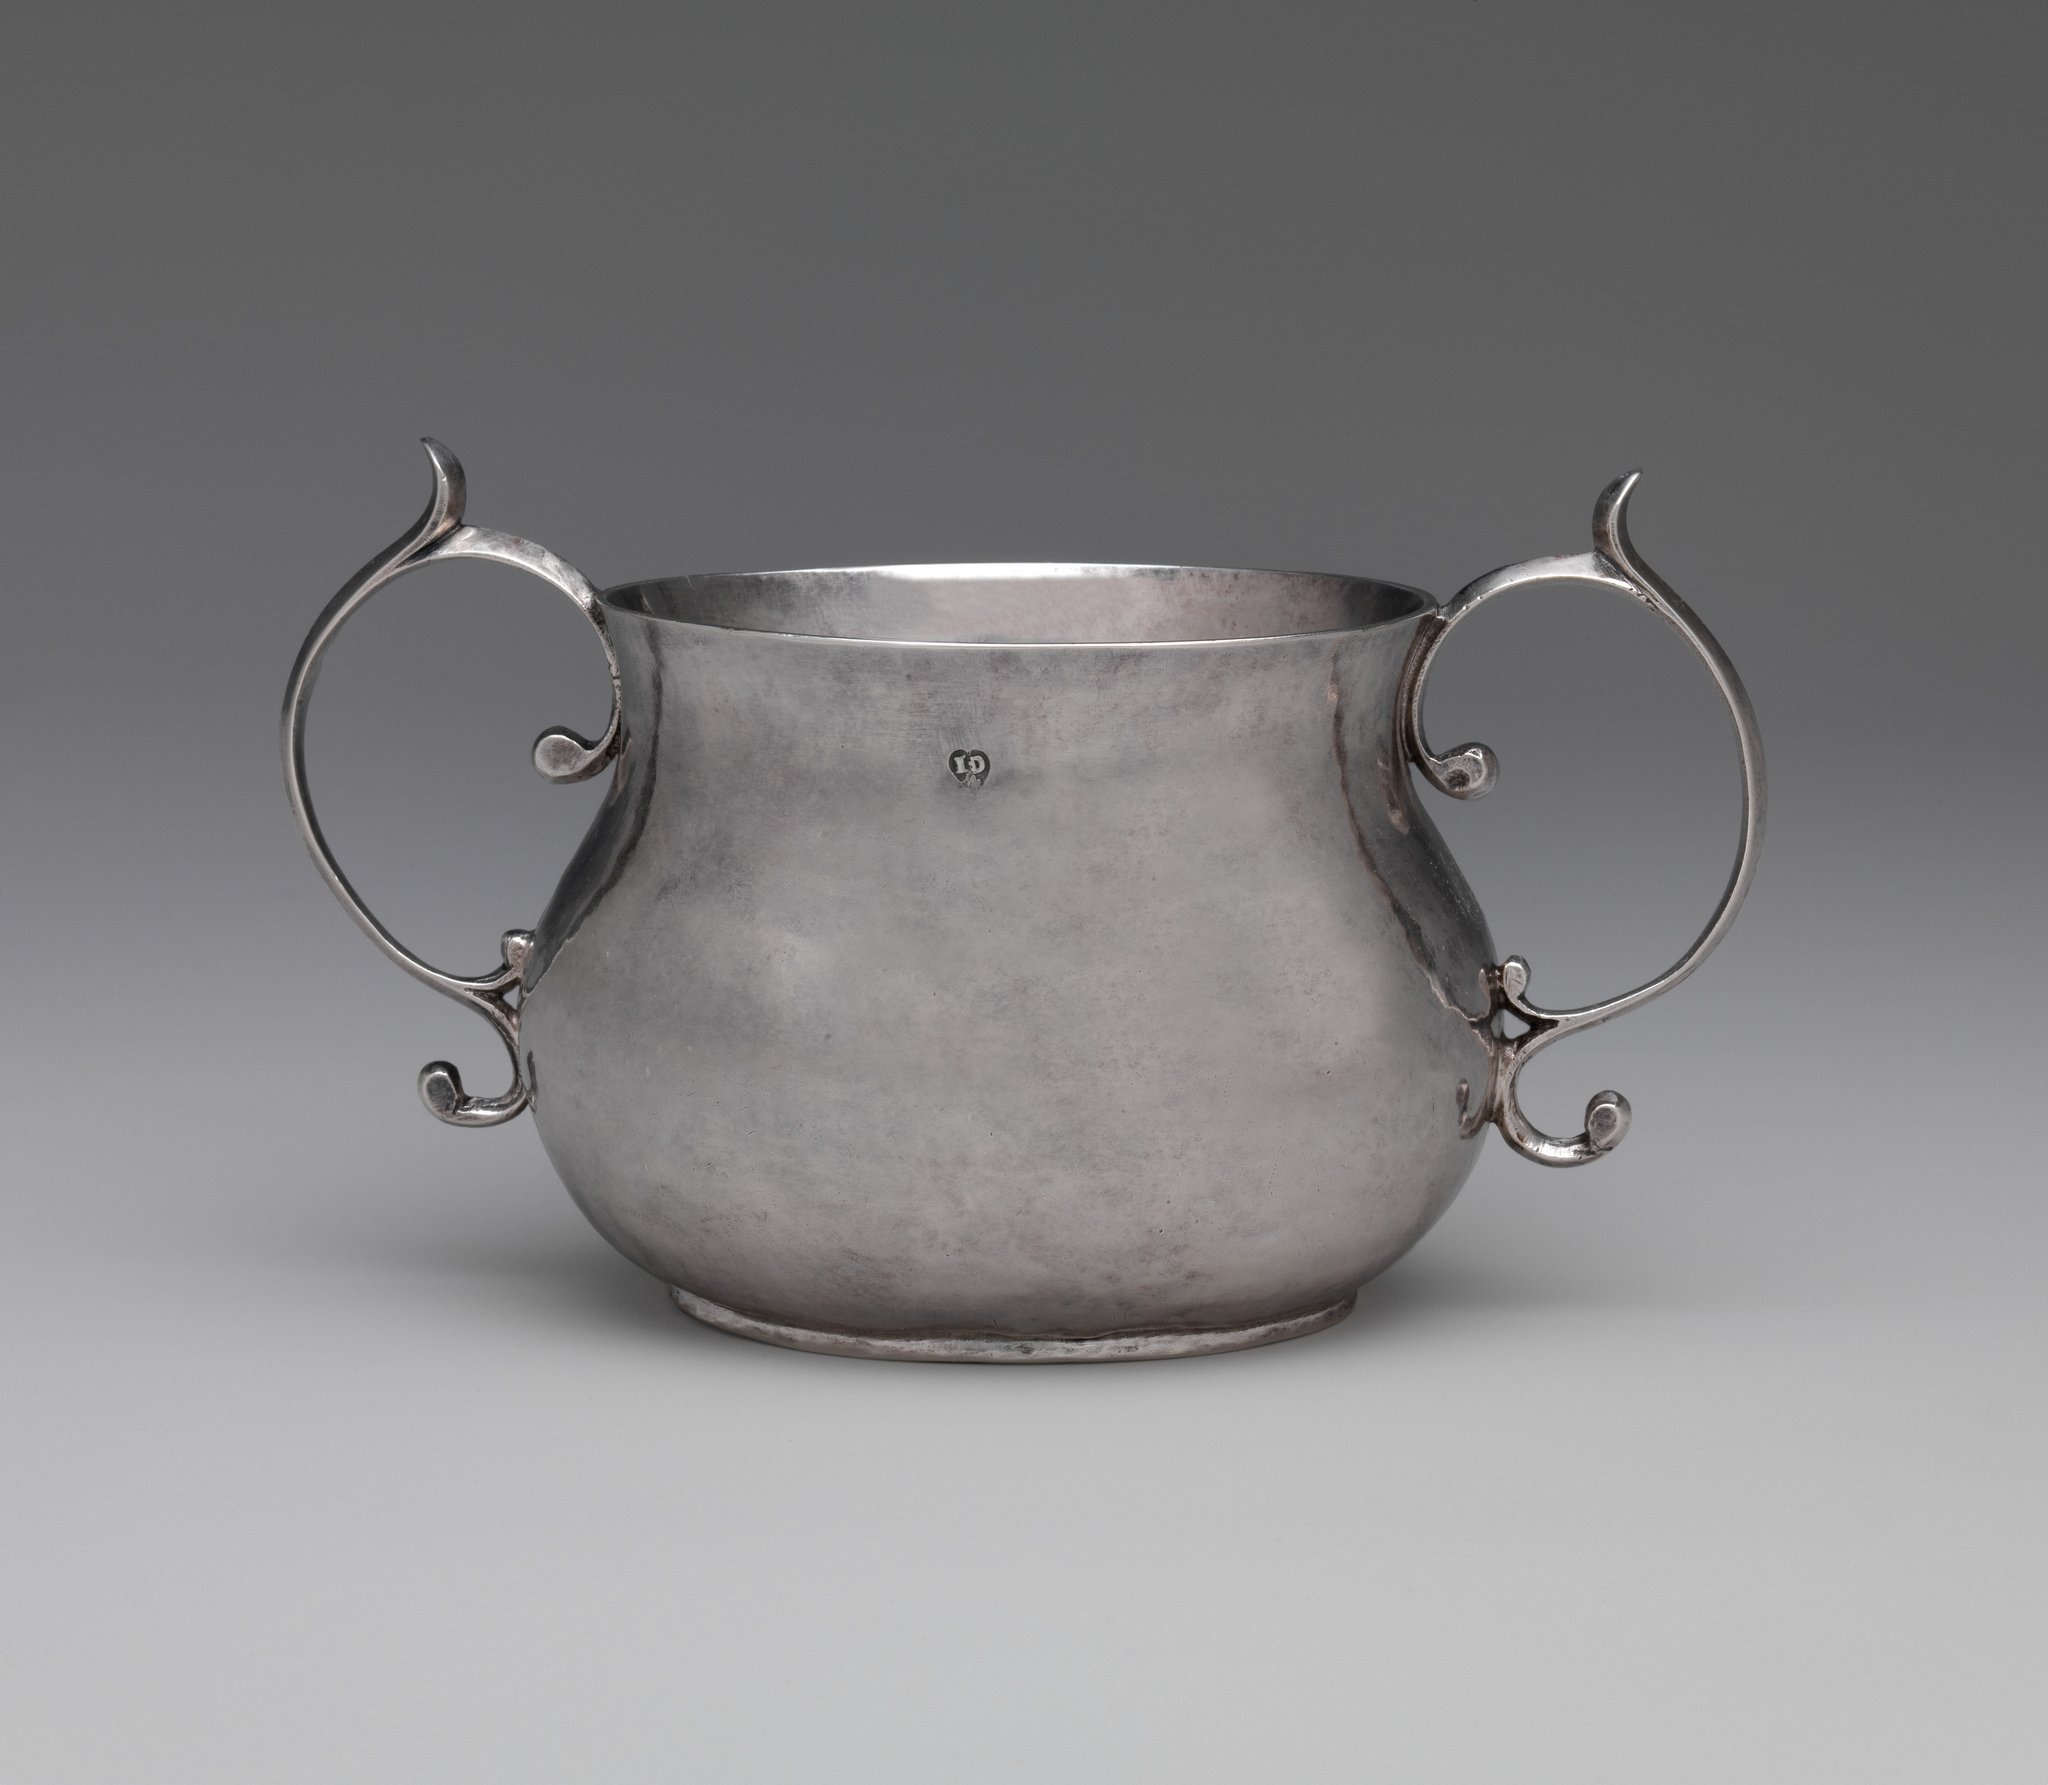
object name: cup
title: Two-Handled Cup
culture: american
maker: jeremiah dummer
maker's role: artist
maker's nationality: american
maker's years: 1645-1718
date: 1690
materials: silver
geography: united states